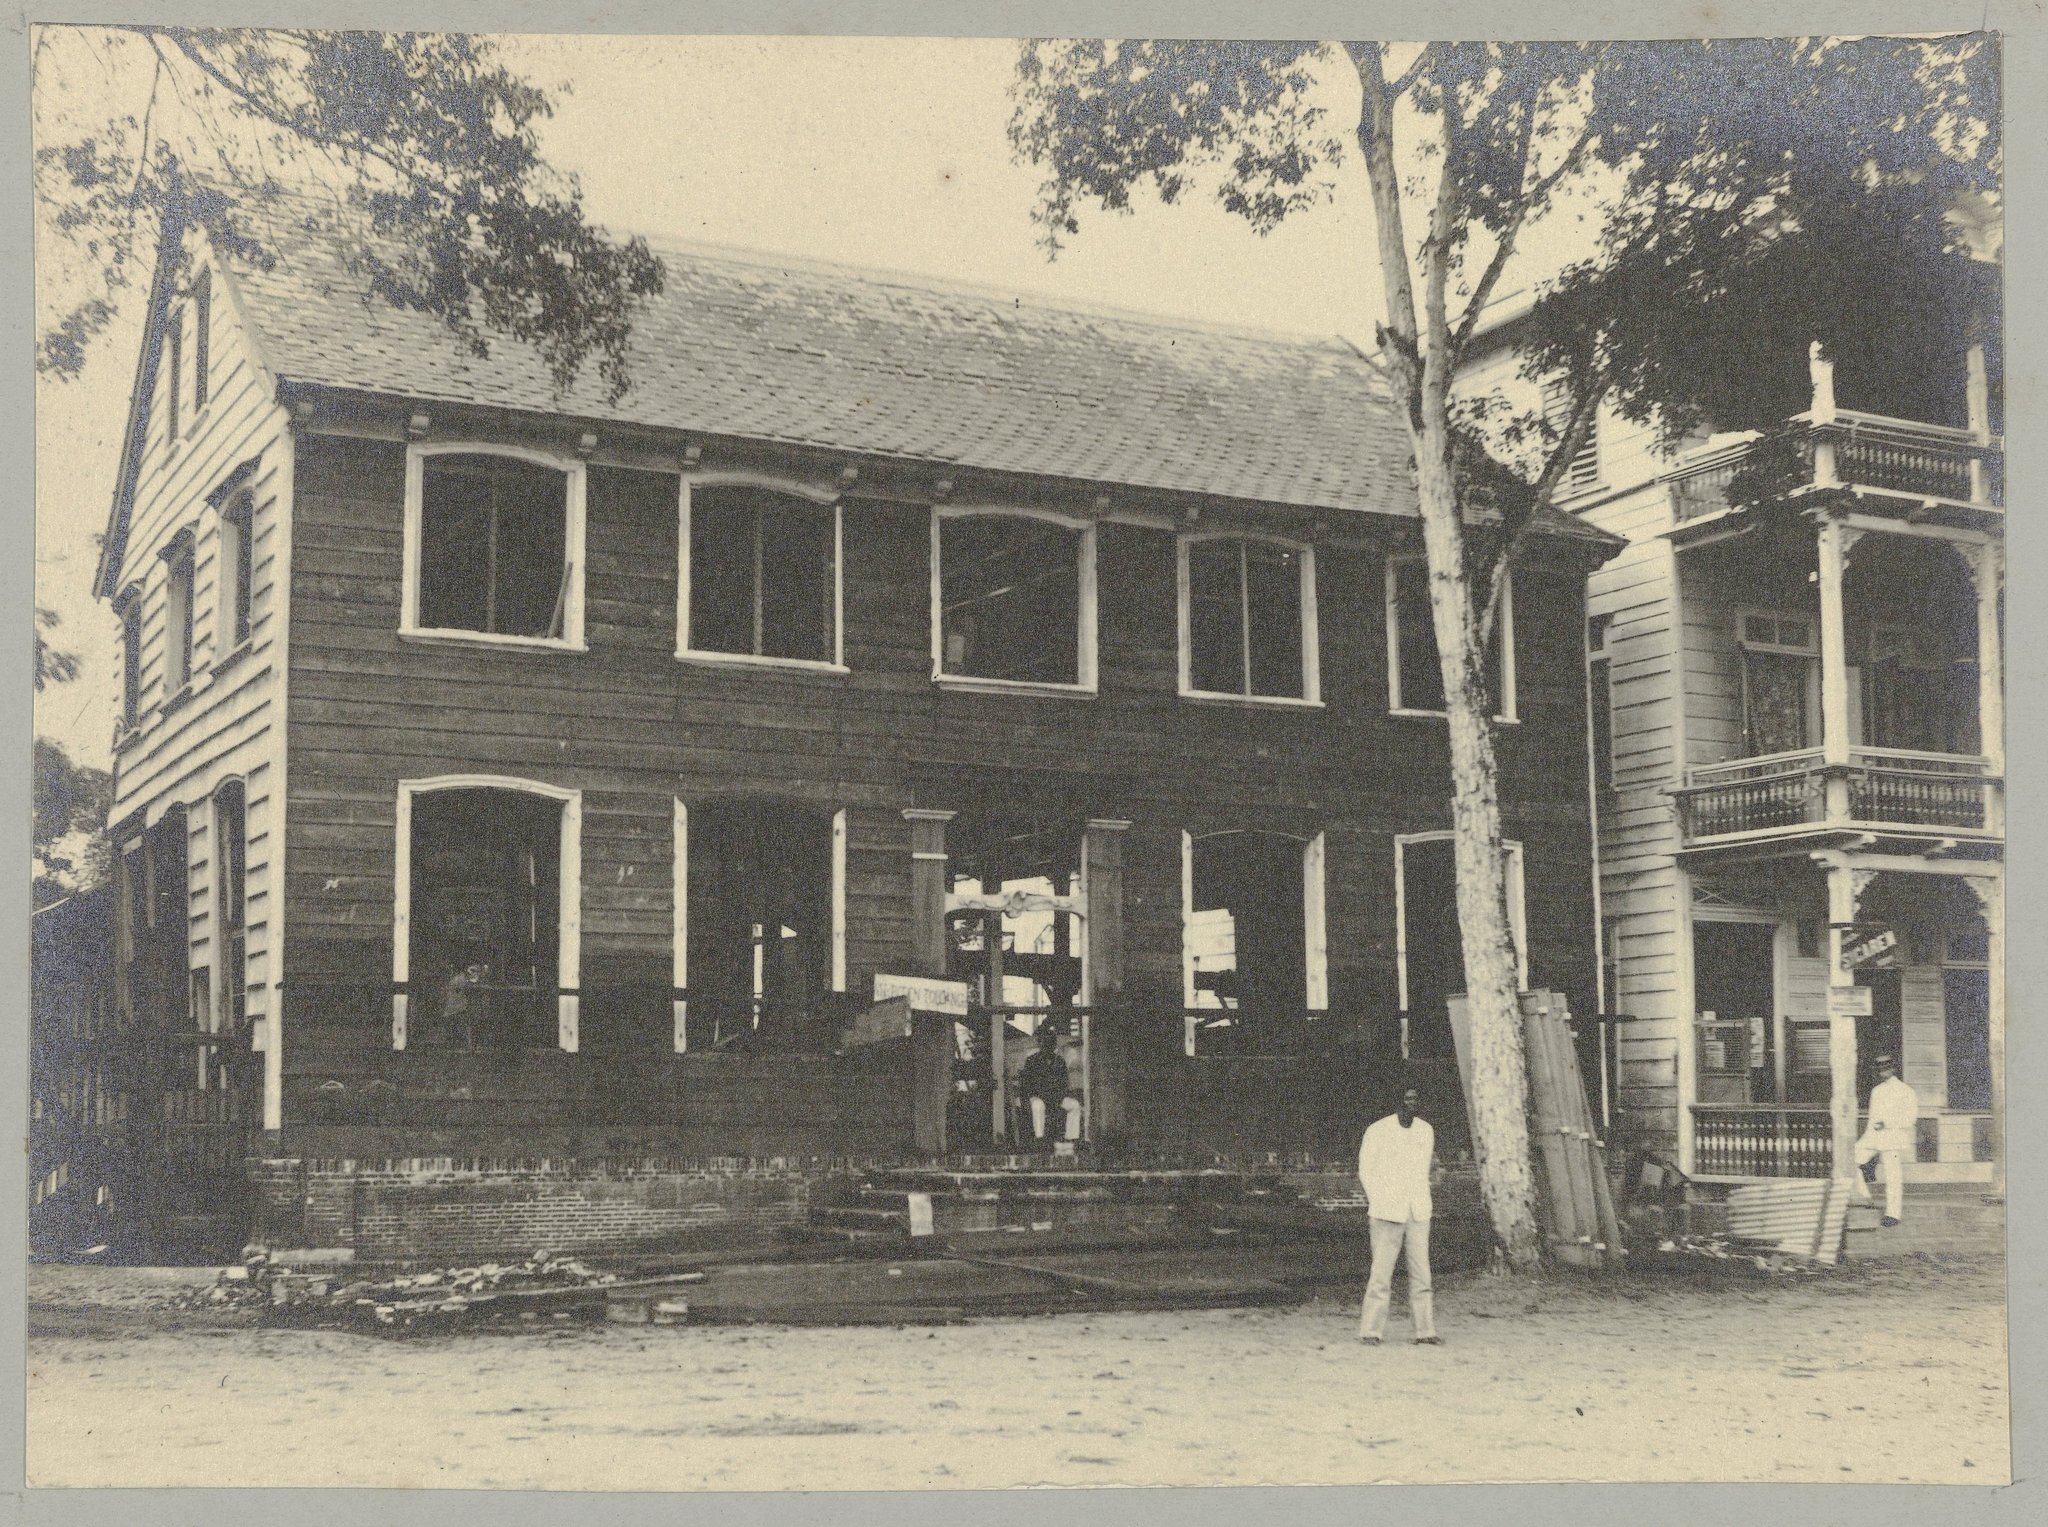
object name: photograph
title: Emmaschool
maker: hendrik doijer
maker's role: engineer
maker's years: 1863-1925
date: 1903-1910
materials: photographic support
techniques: gelatin silver print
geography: suriname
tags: suriname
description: De Emmaschool te Paramaribo in aanbouw, gezicht vanaf de straat. Onderdeel van het fotoalbum Souvenir de Voyage (deel 4), over het leven van de familie Doijer in en rond de plantage Ma Retraite in Suriname in de jaren 1903-1910.